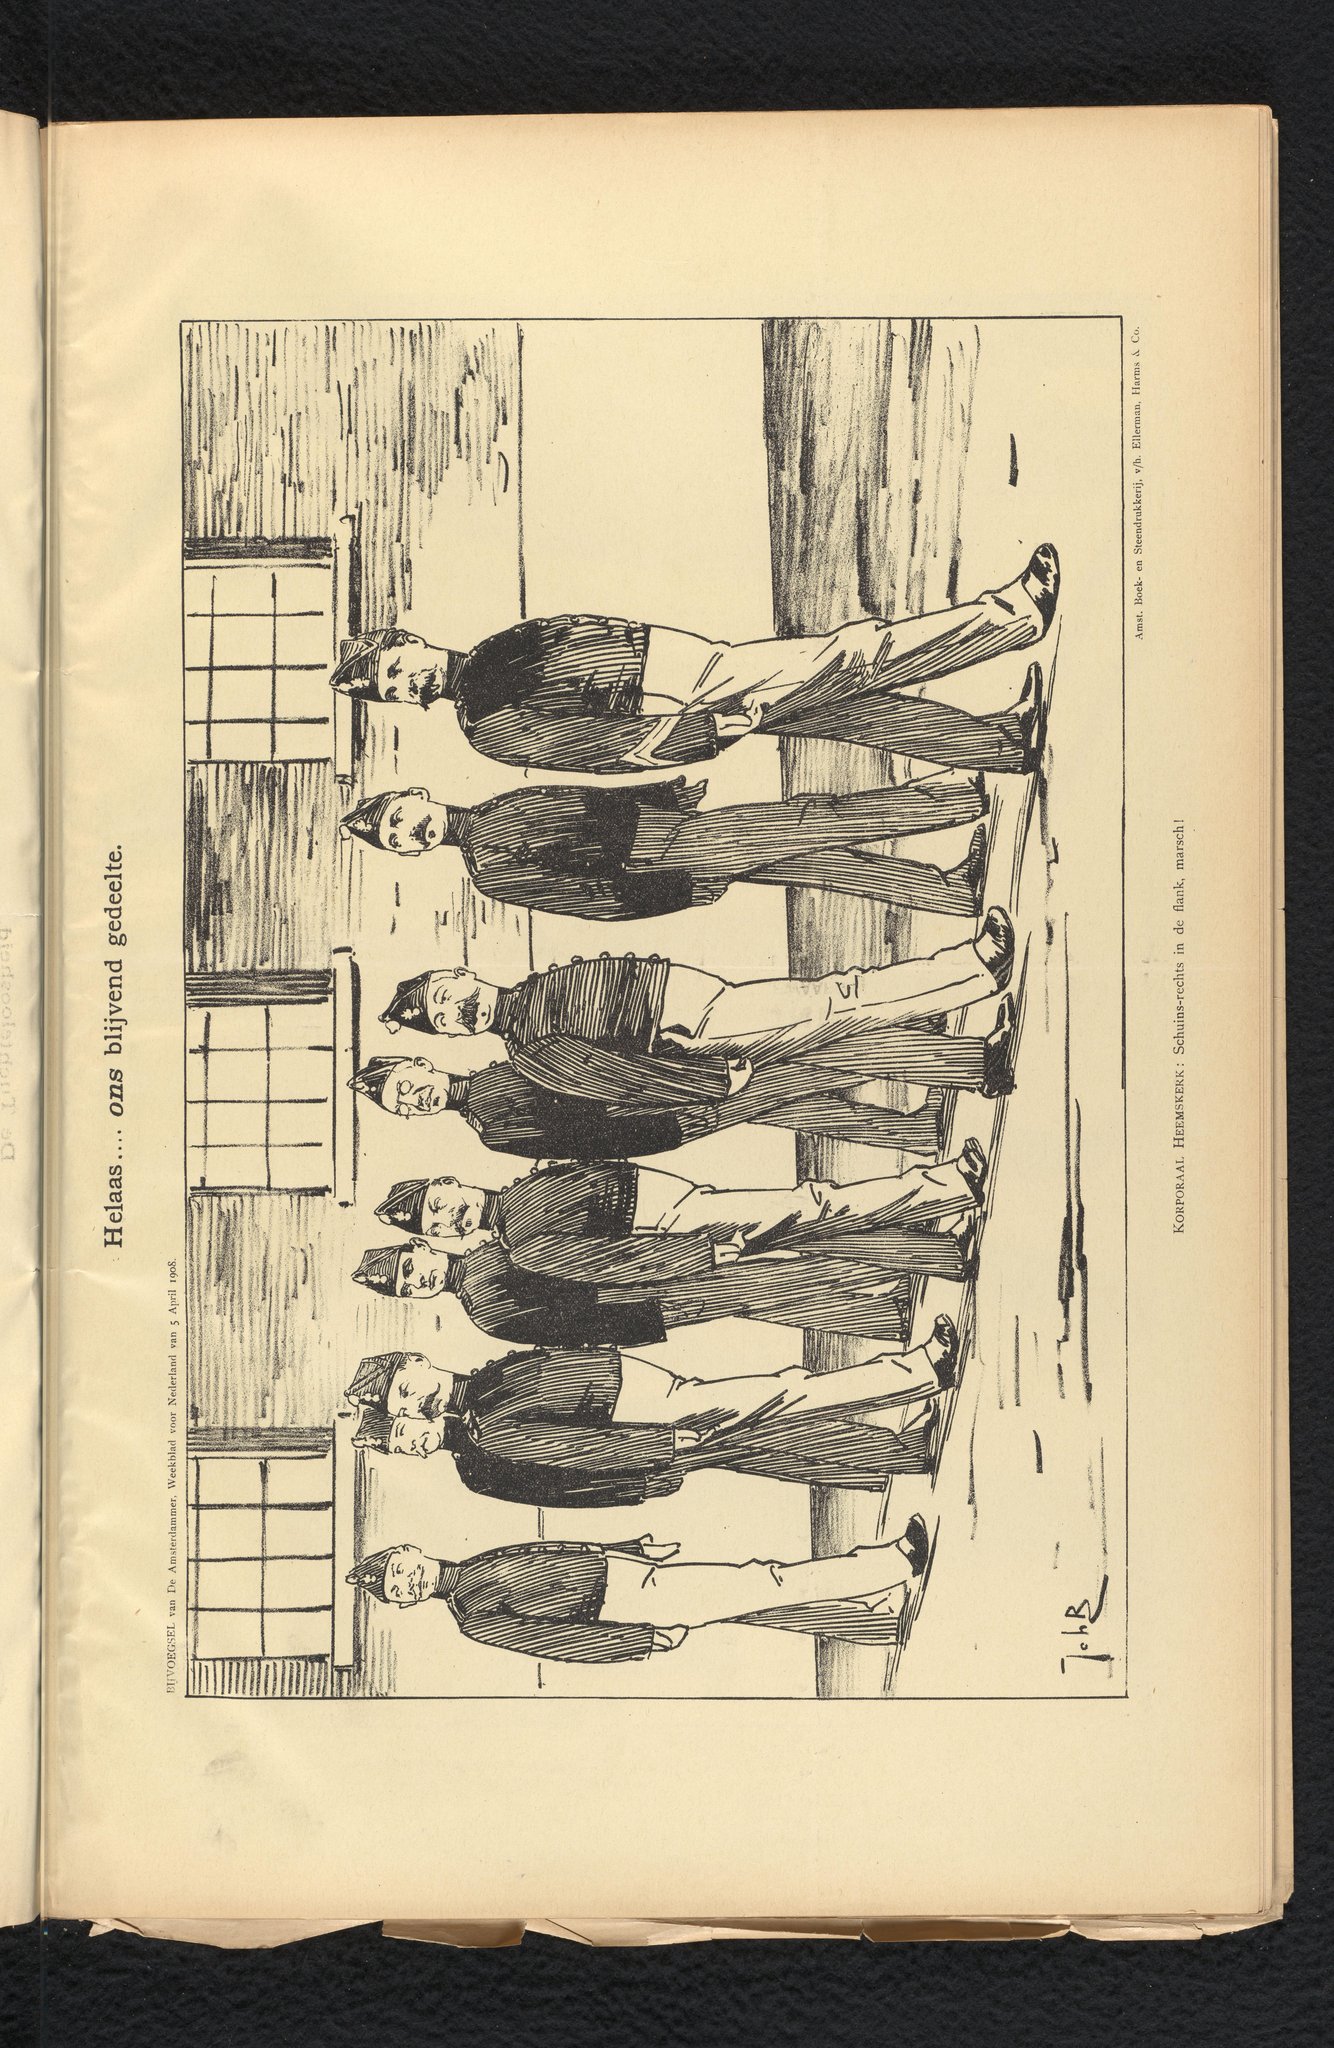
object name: cartoon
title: Helaas ... ons blijvend gedeelte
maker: johan braakensiek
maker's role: draughtsman, print maker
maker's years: 1858-1940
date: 1908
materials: paper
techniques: lithograph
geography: amsterdam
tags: prime minister, minister ~ government, drill ~ military training, political caricatures and satires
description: Premier Heemskerk leidt als een korporaal zijn ministersploeg als soldaten in de mars.